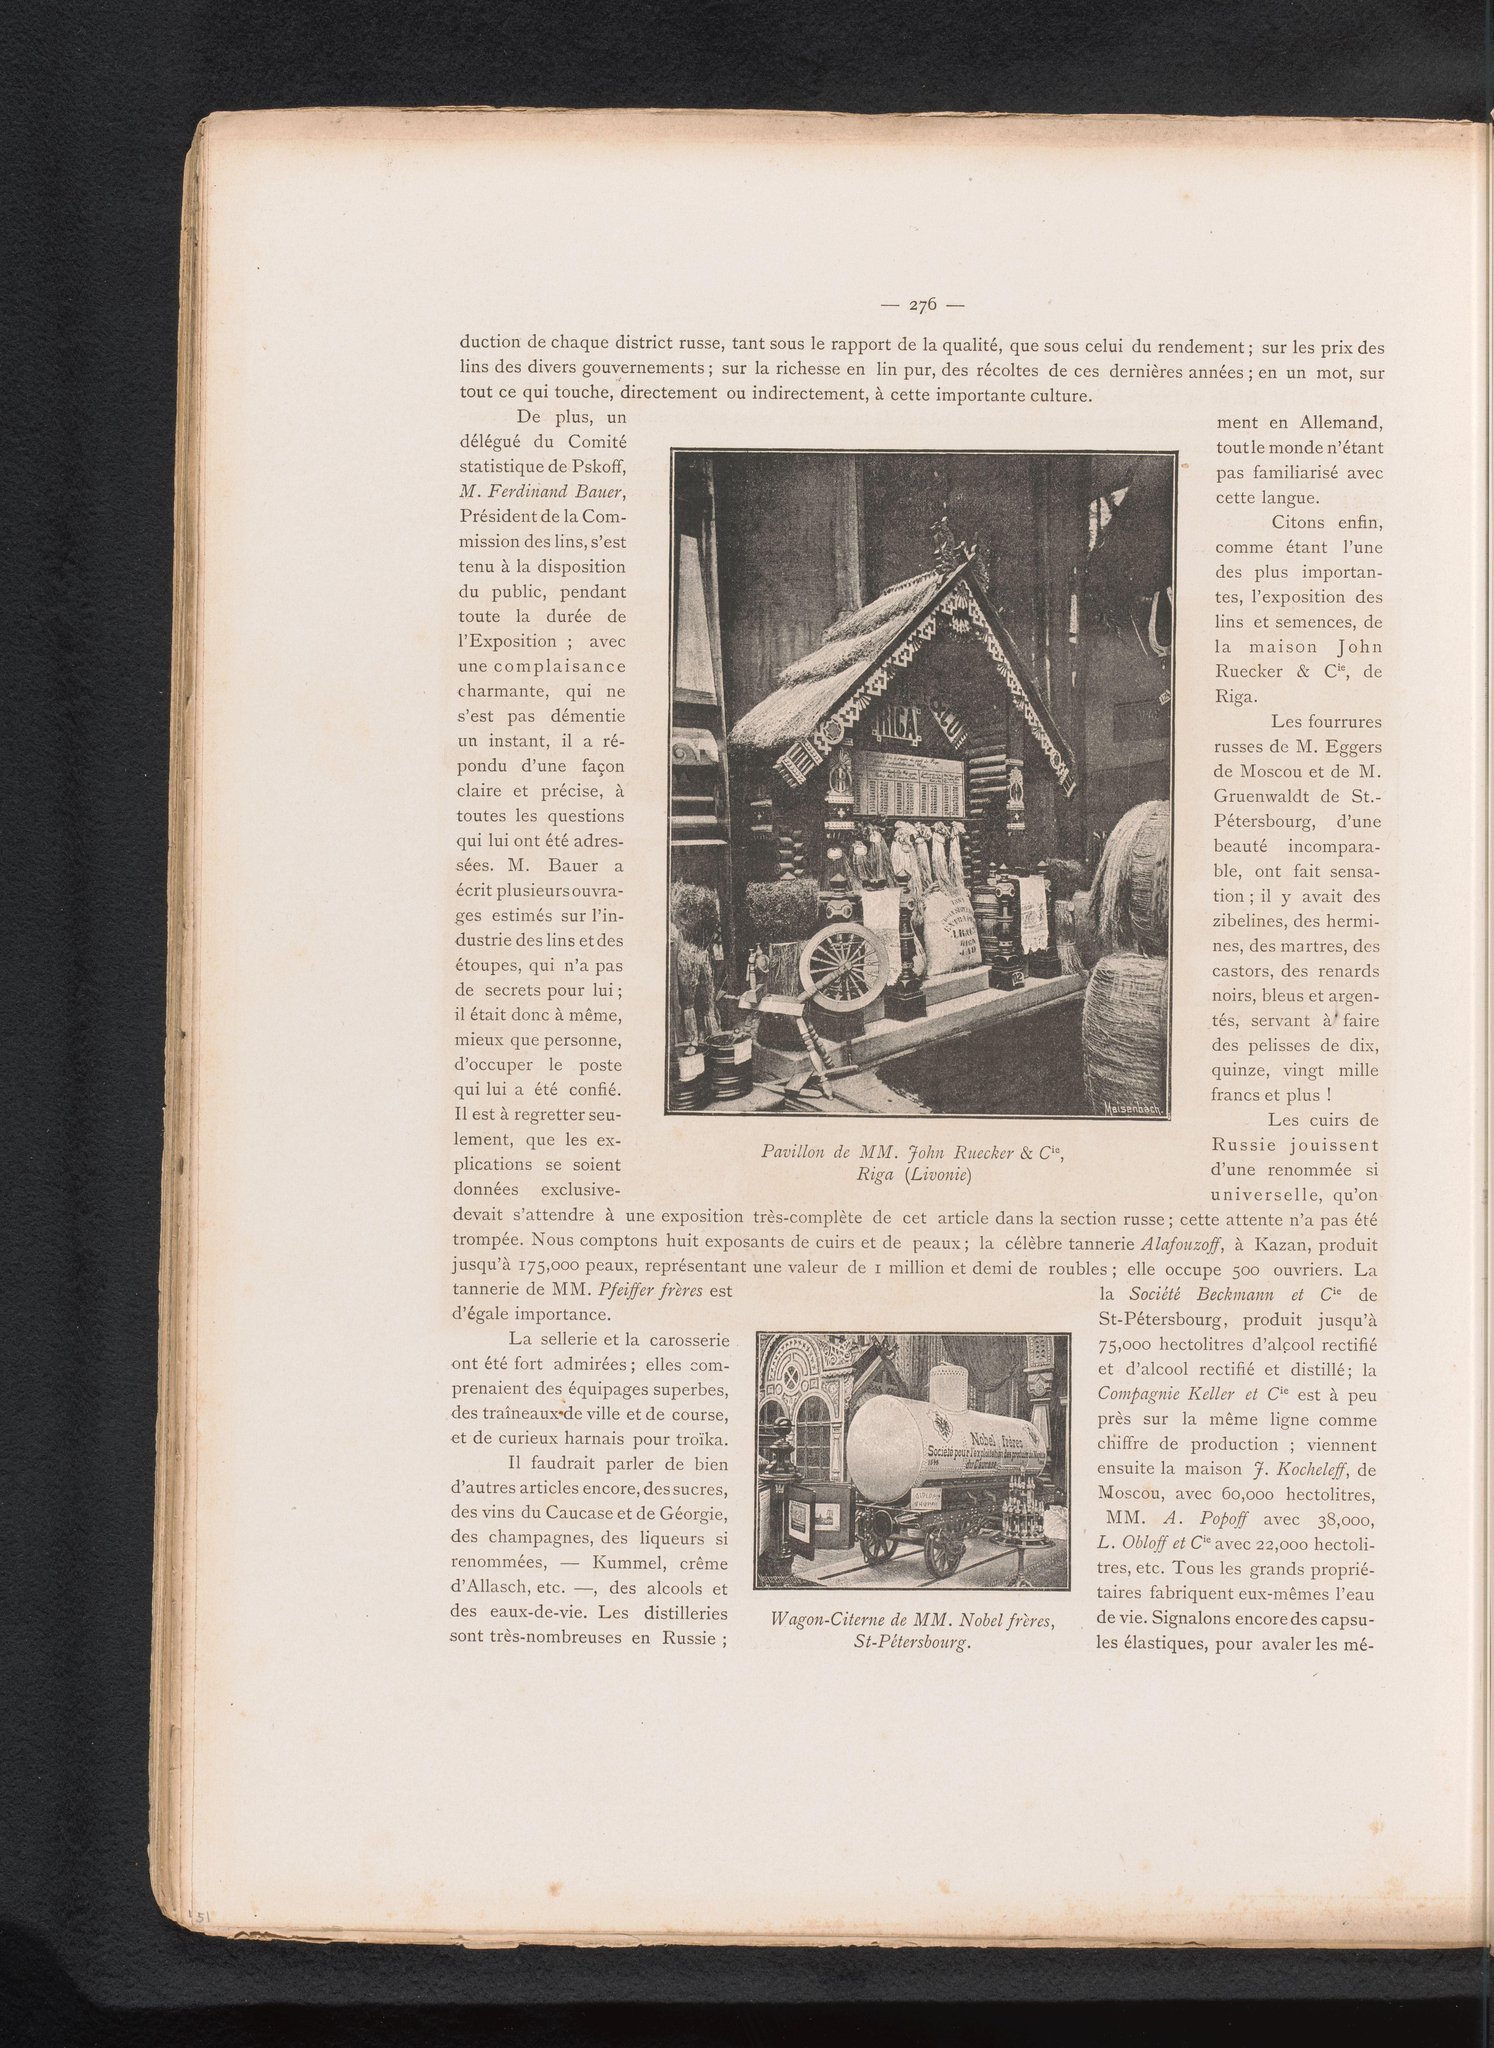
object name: page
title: Pavillon de MM. John Ruecker & Cie, Riga (Livonie)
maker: Anonymous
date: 1880-1885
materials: paper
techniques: autotype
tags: world fair, world exhibition, antwerp